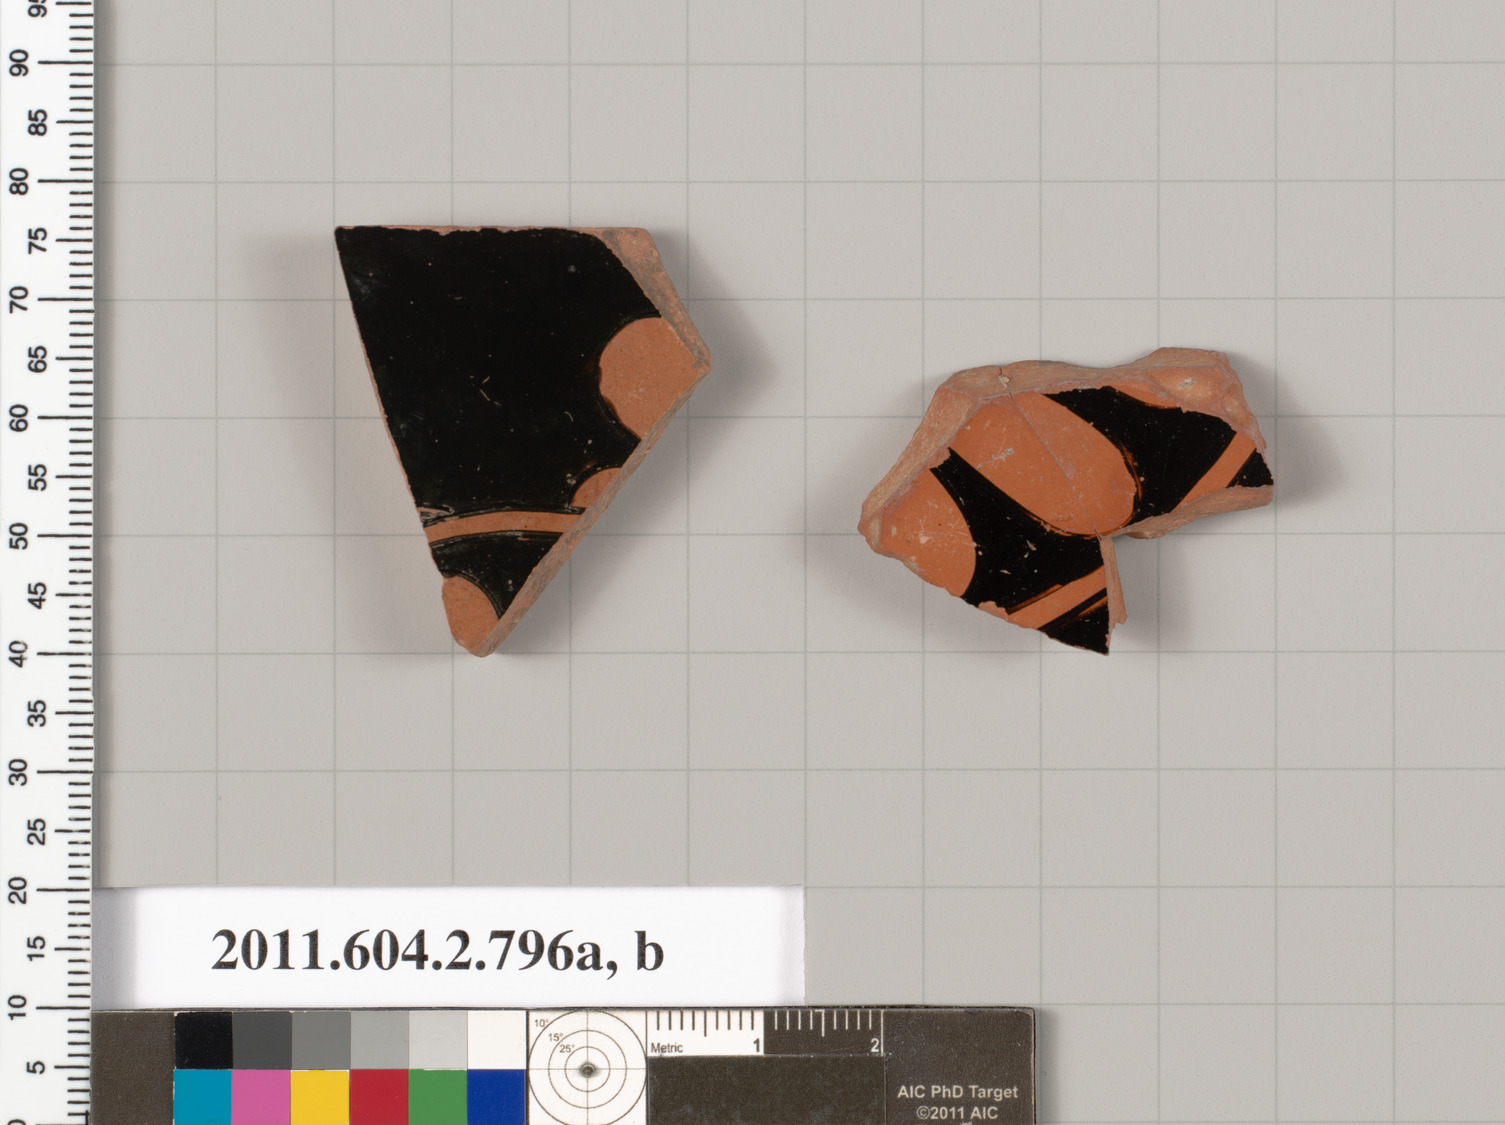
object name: calyx krater fragment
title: Terracotta fragments of calyx-kraters (bowls for mixing wine and water)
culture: greek, attic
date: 500-476 BCE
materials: terracotta